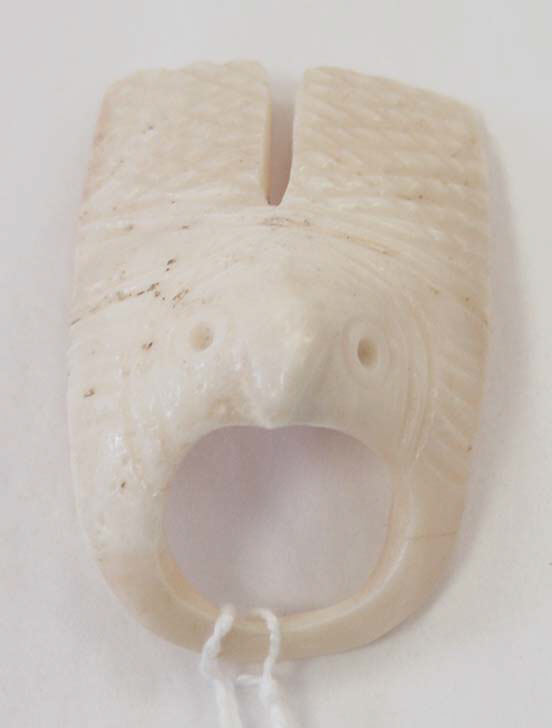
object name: ring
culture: indigenous american, pre-columbian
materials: bone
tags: birds